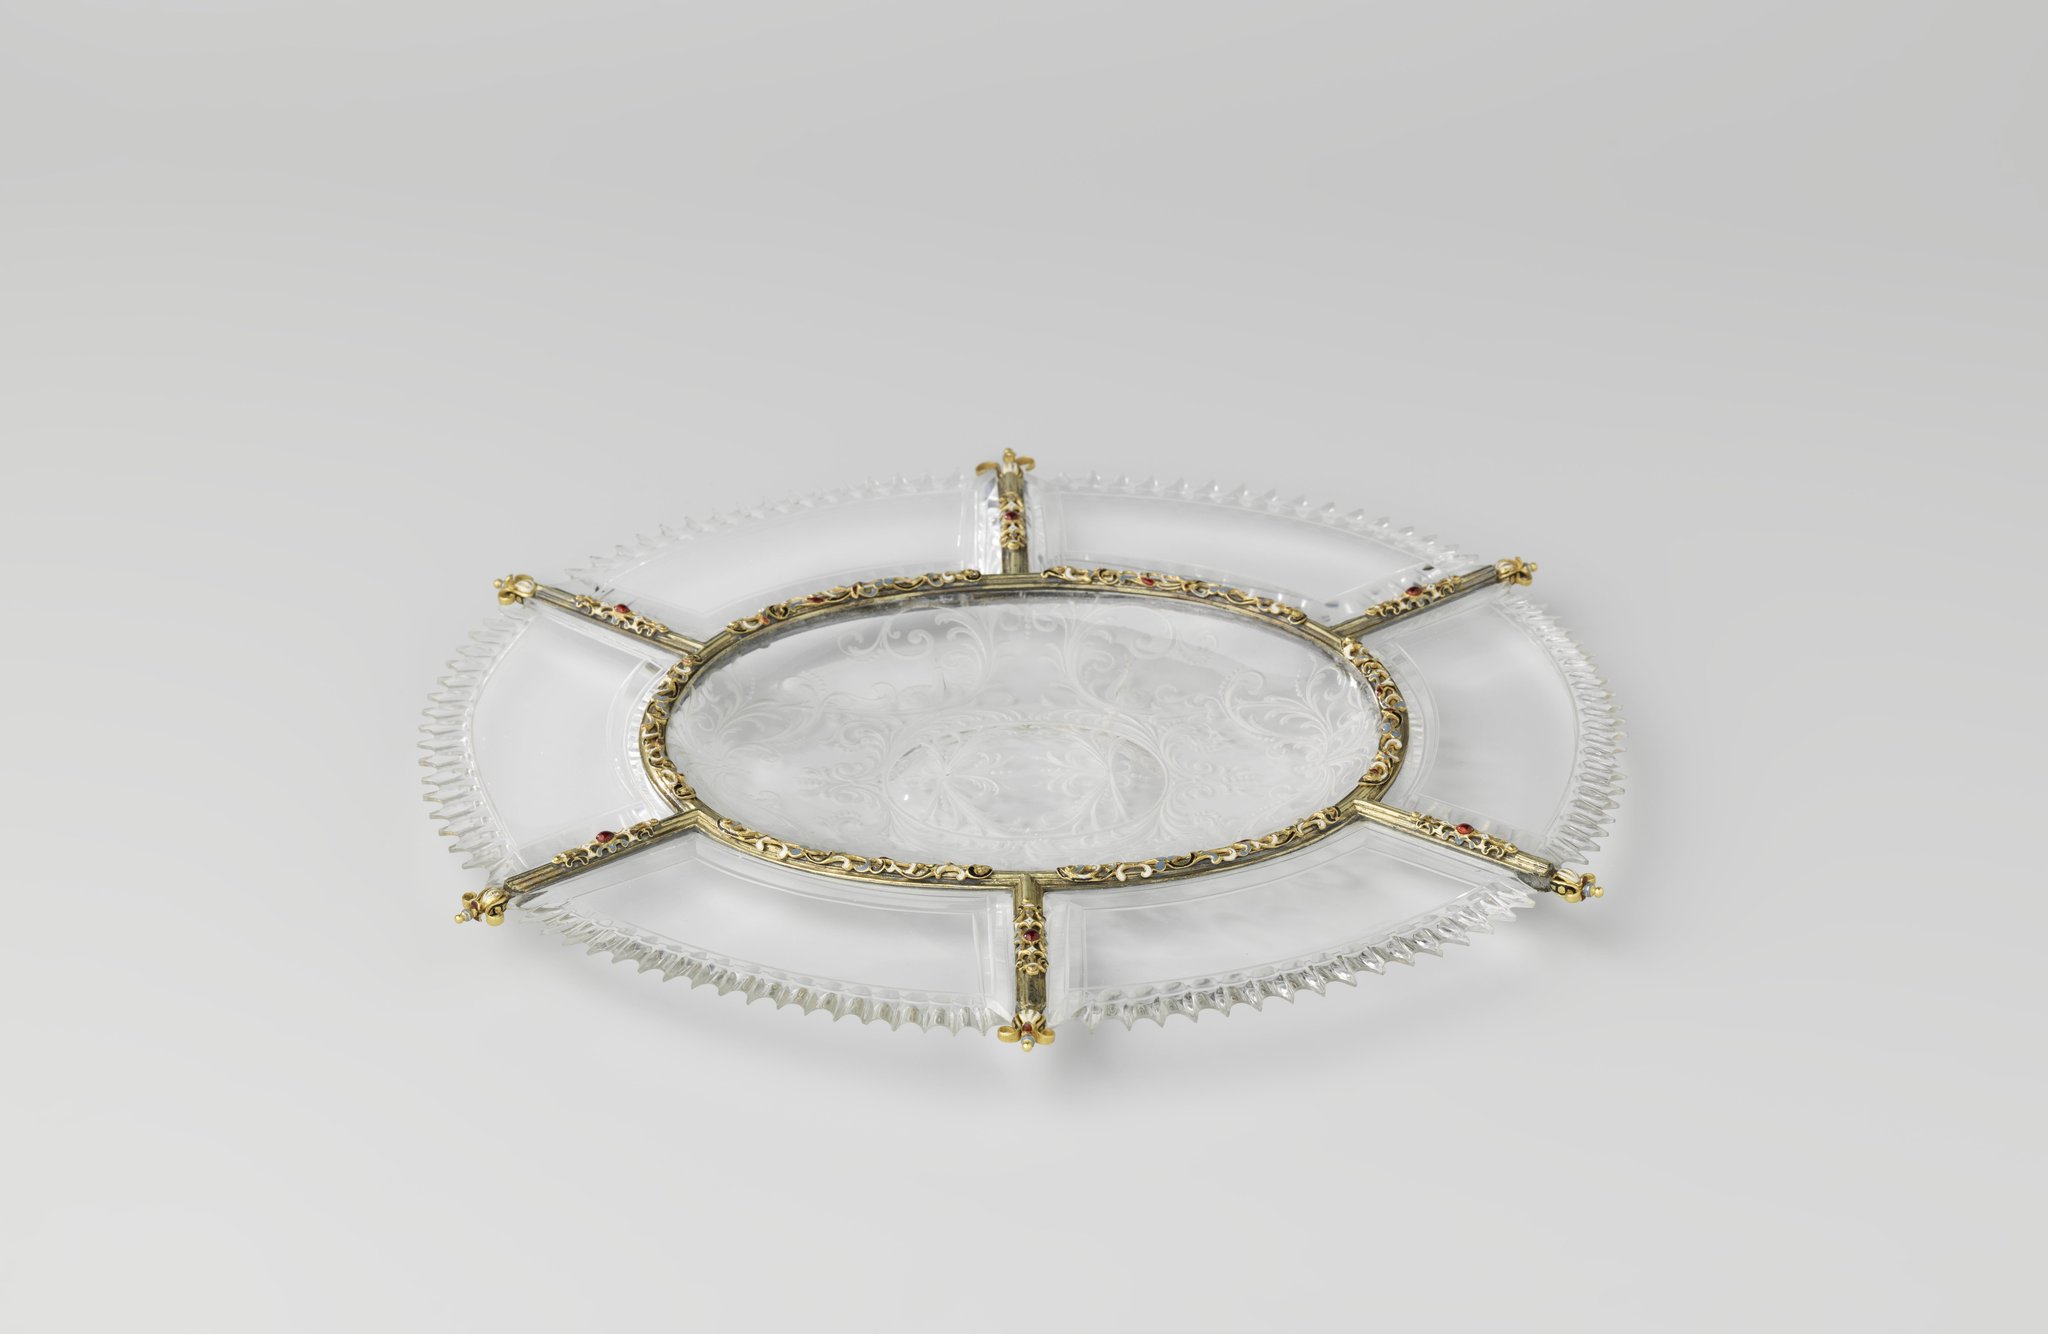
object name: dish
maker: Anonymous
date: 1625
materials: gold, silver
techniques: gilding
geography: prague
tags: ornaments ~ art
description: Platte, ovale schaal van bergkristal in een montuur van goud met opgelegde motieven van email. In het plat zijn acanthusranken en vier huisjesslakken in mat slijpwerk afgebeeld.